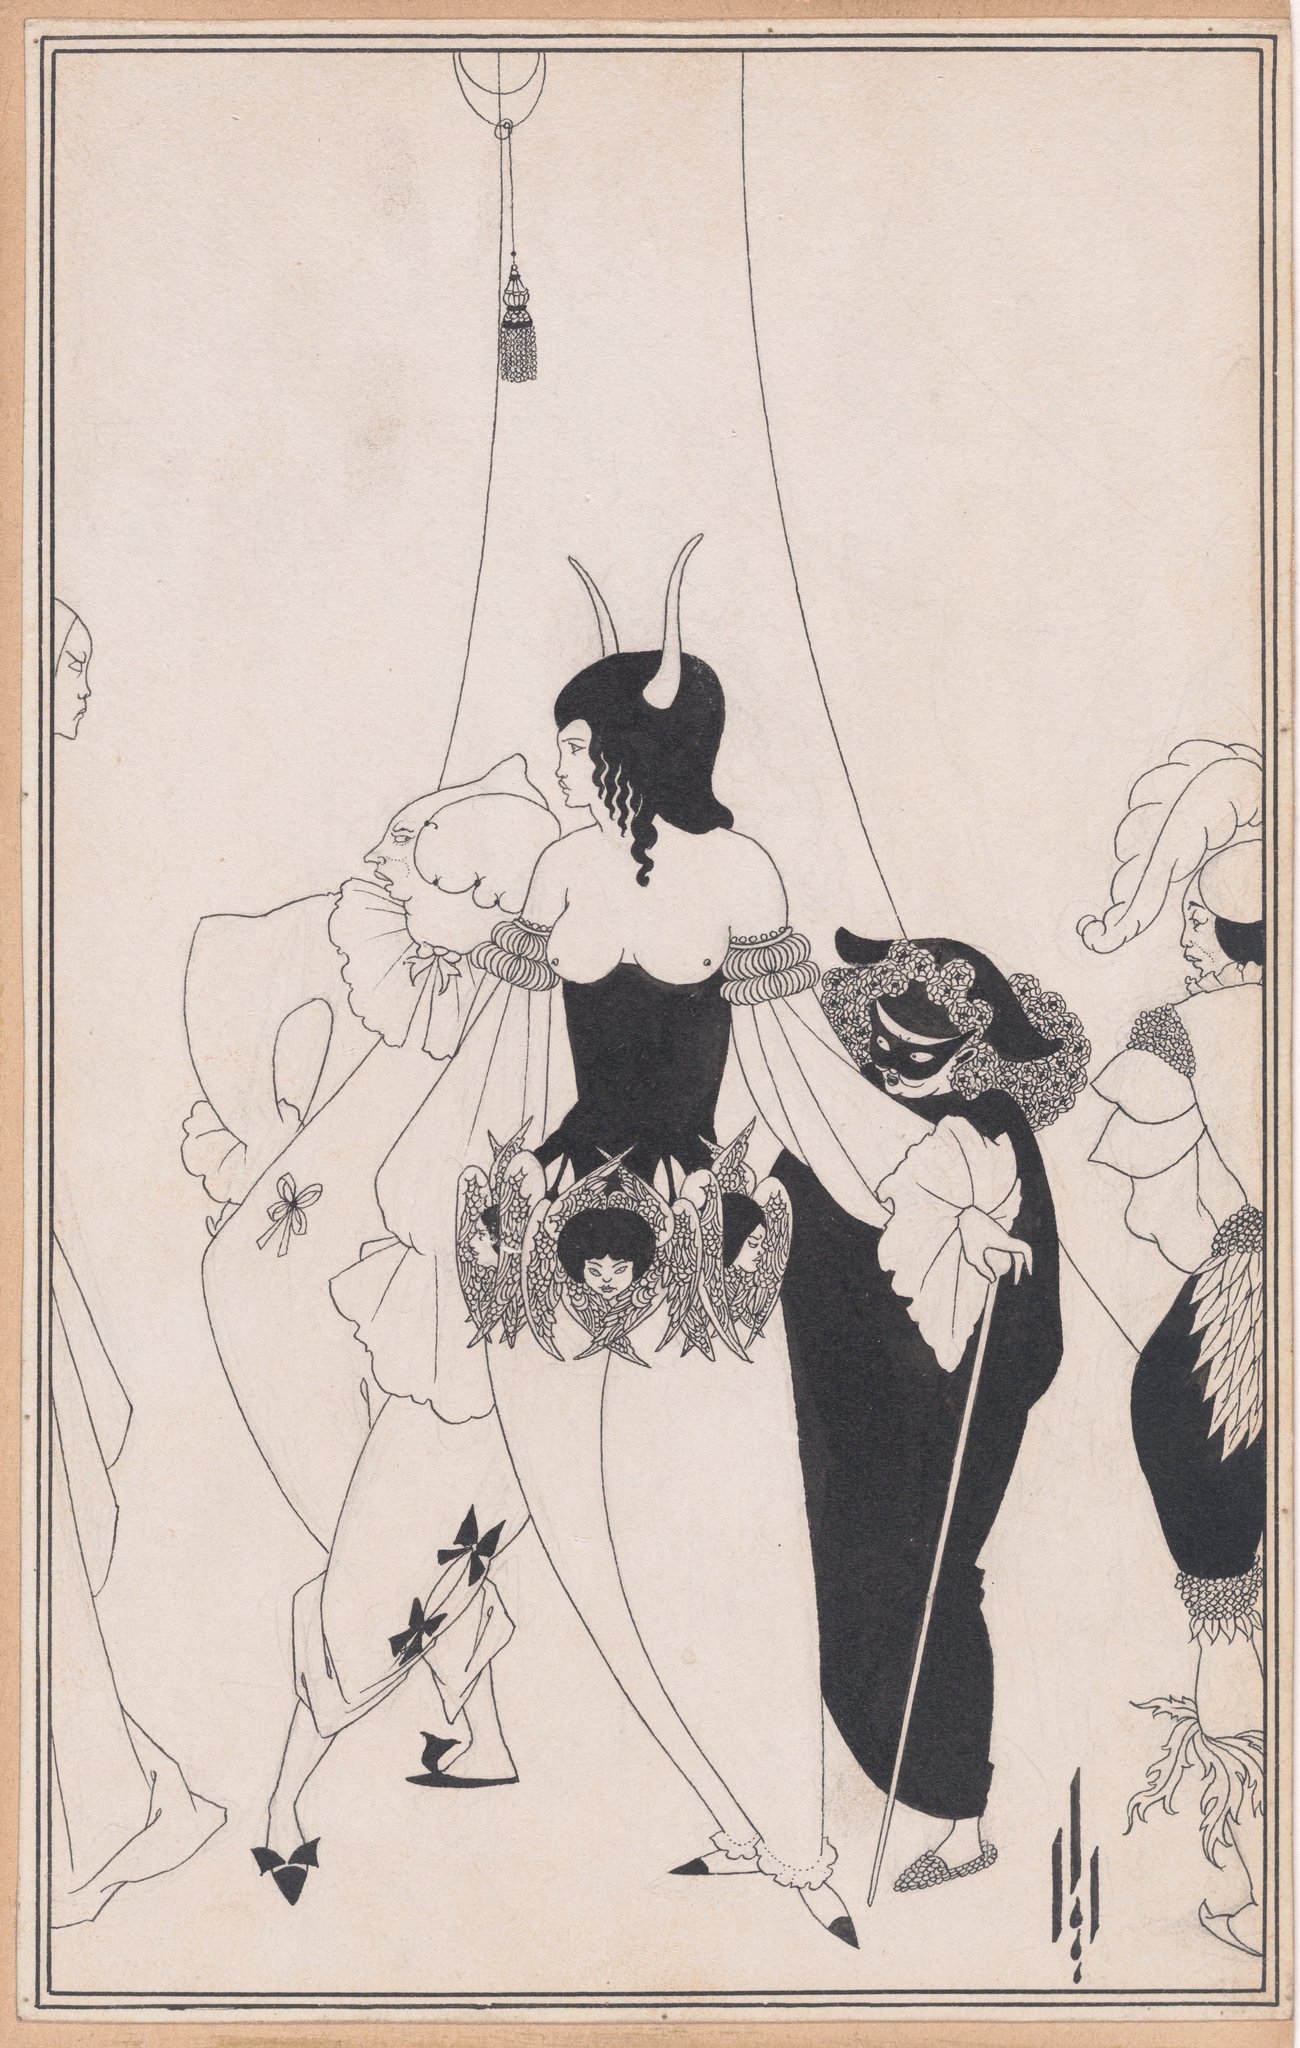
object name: drawing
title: The Masque of the Red Death, for Edgar Allan Poe’s “Tales of Mystery and the Imagination,” Chicago, 1895–96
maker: aubrey vincent beardsley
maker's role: artist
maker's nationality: british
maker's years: 1872-1898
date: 1894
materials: graphite, ink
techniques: brush, pen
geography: great britain